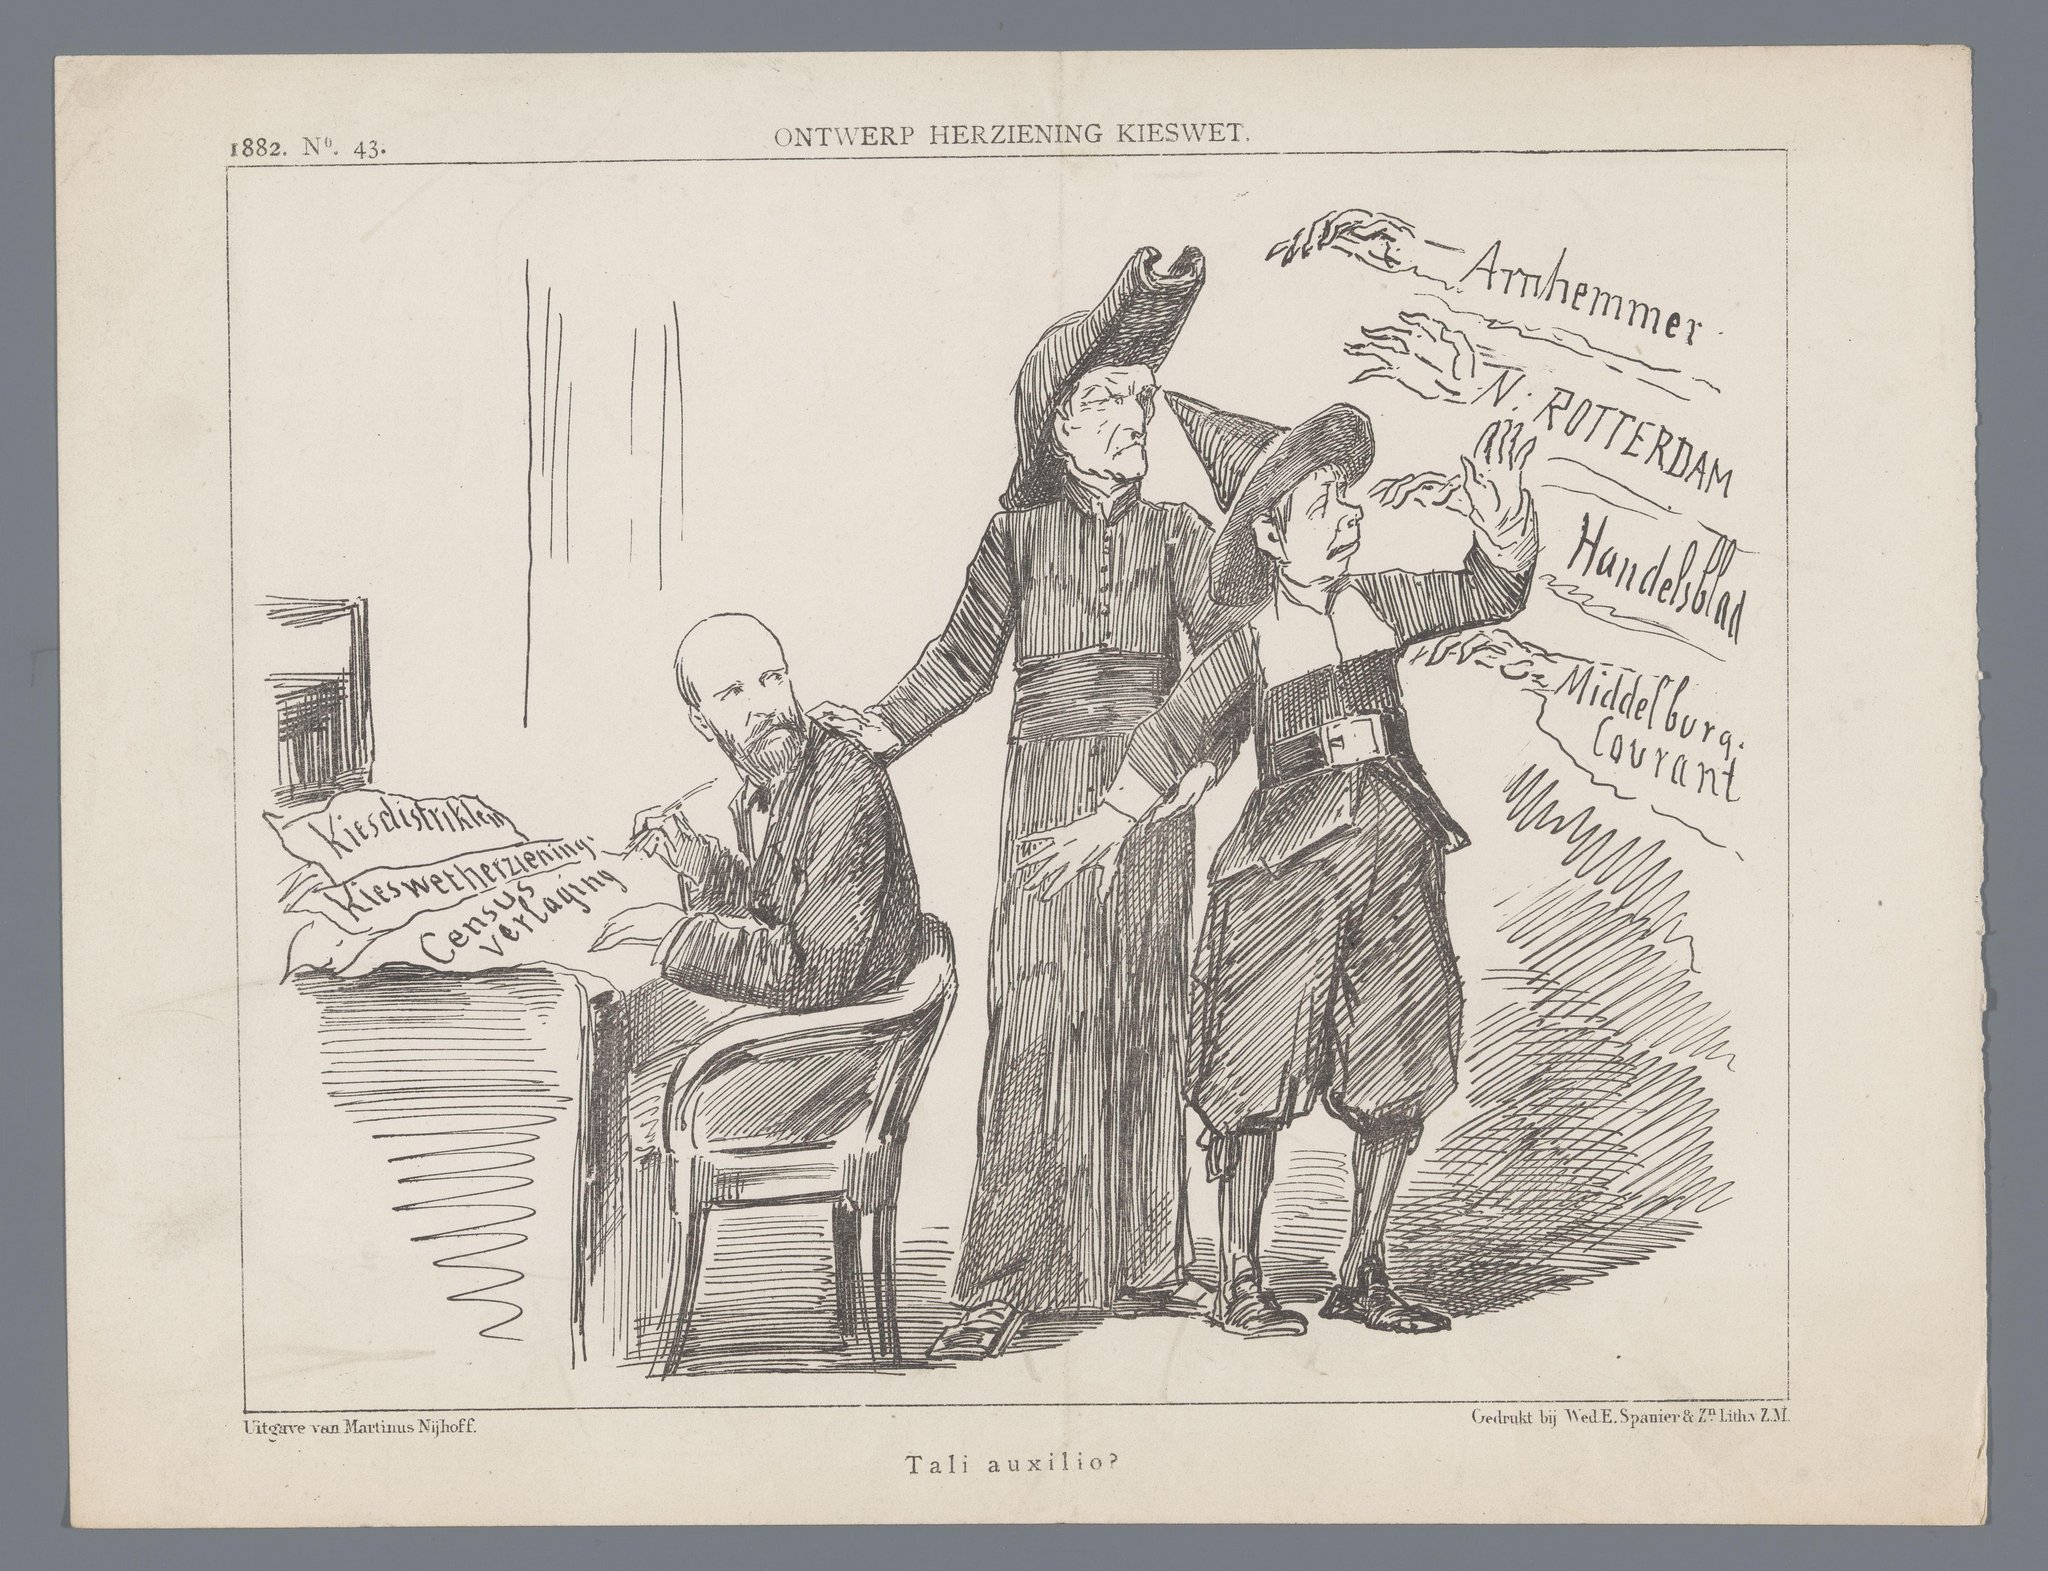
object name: cartoon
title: Ontwerp herziening kieswet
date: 1882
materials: paper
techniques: lithograph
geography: netherlands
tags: winschoten, hoogleraar, jurist, anthony ewoud jan modderman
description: Politieke spotprent over de herziening van de kieswet met minister Anthony Modderman. Plaat verschenen bij het weekblad De Nederlandsche Spectator, nr. 43, 1882.